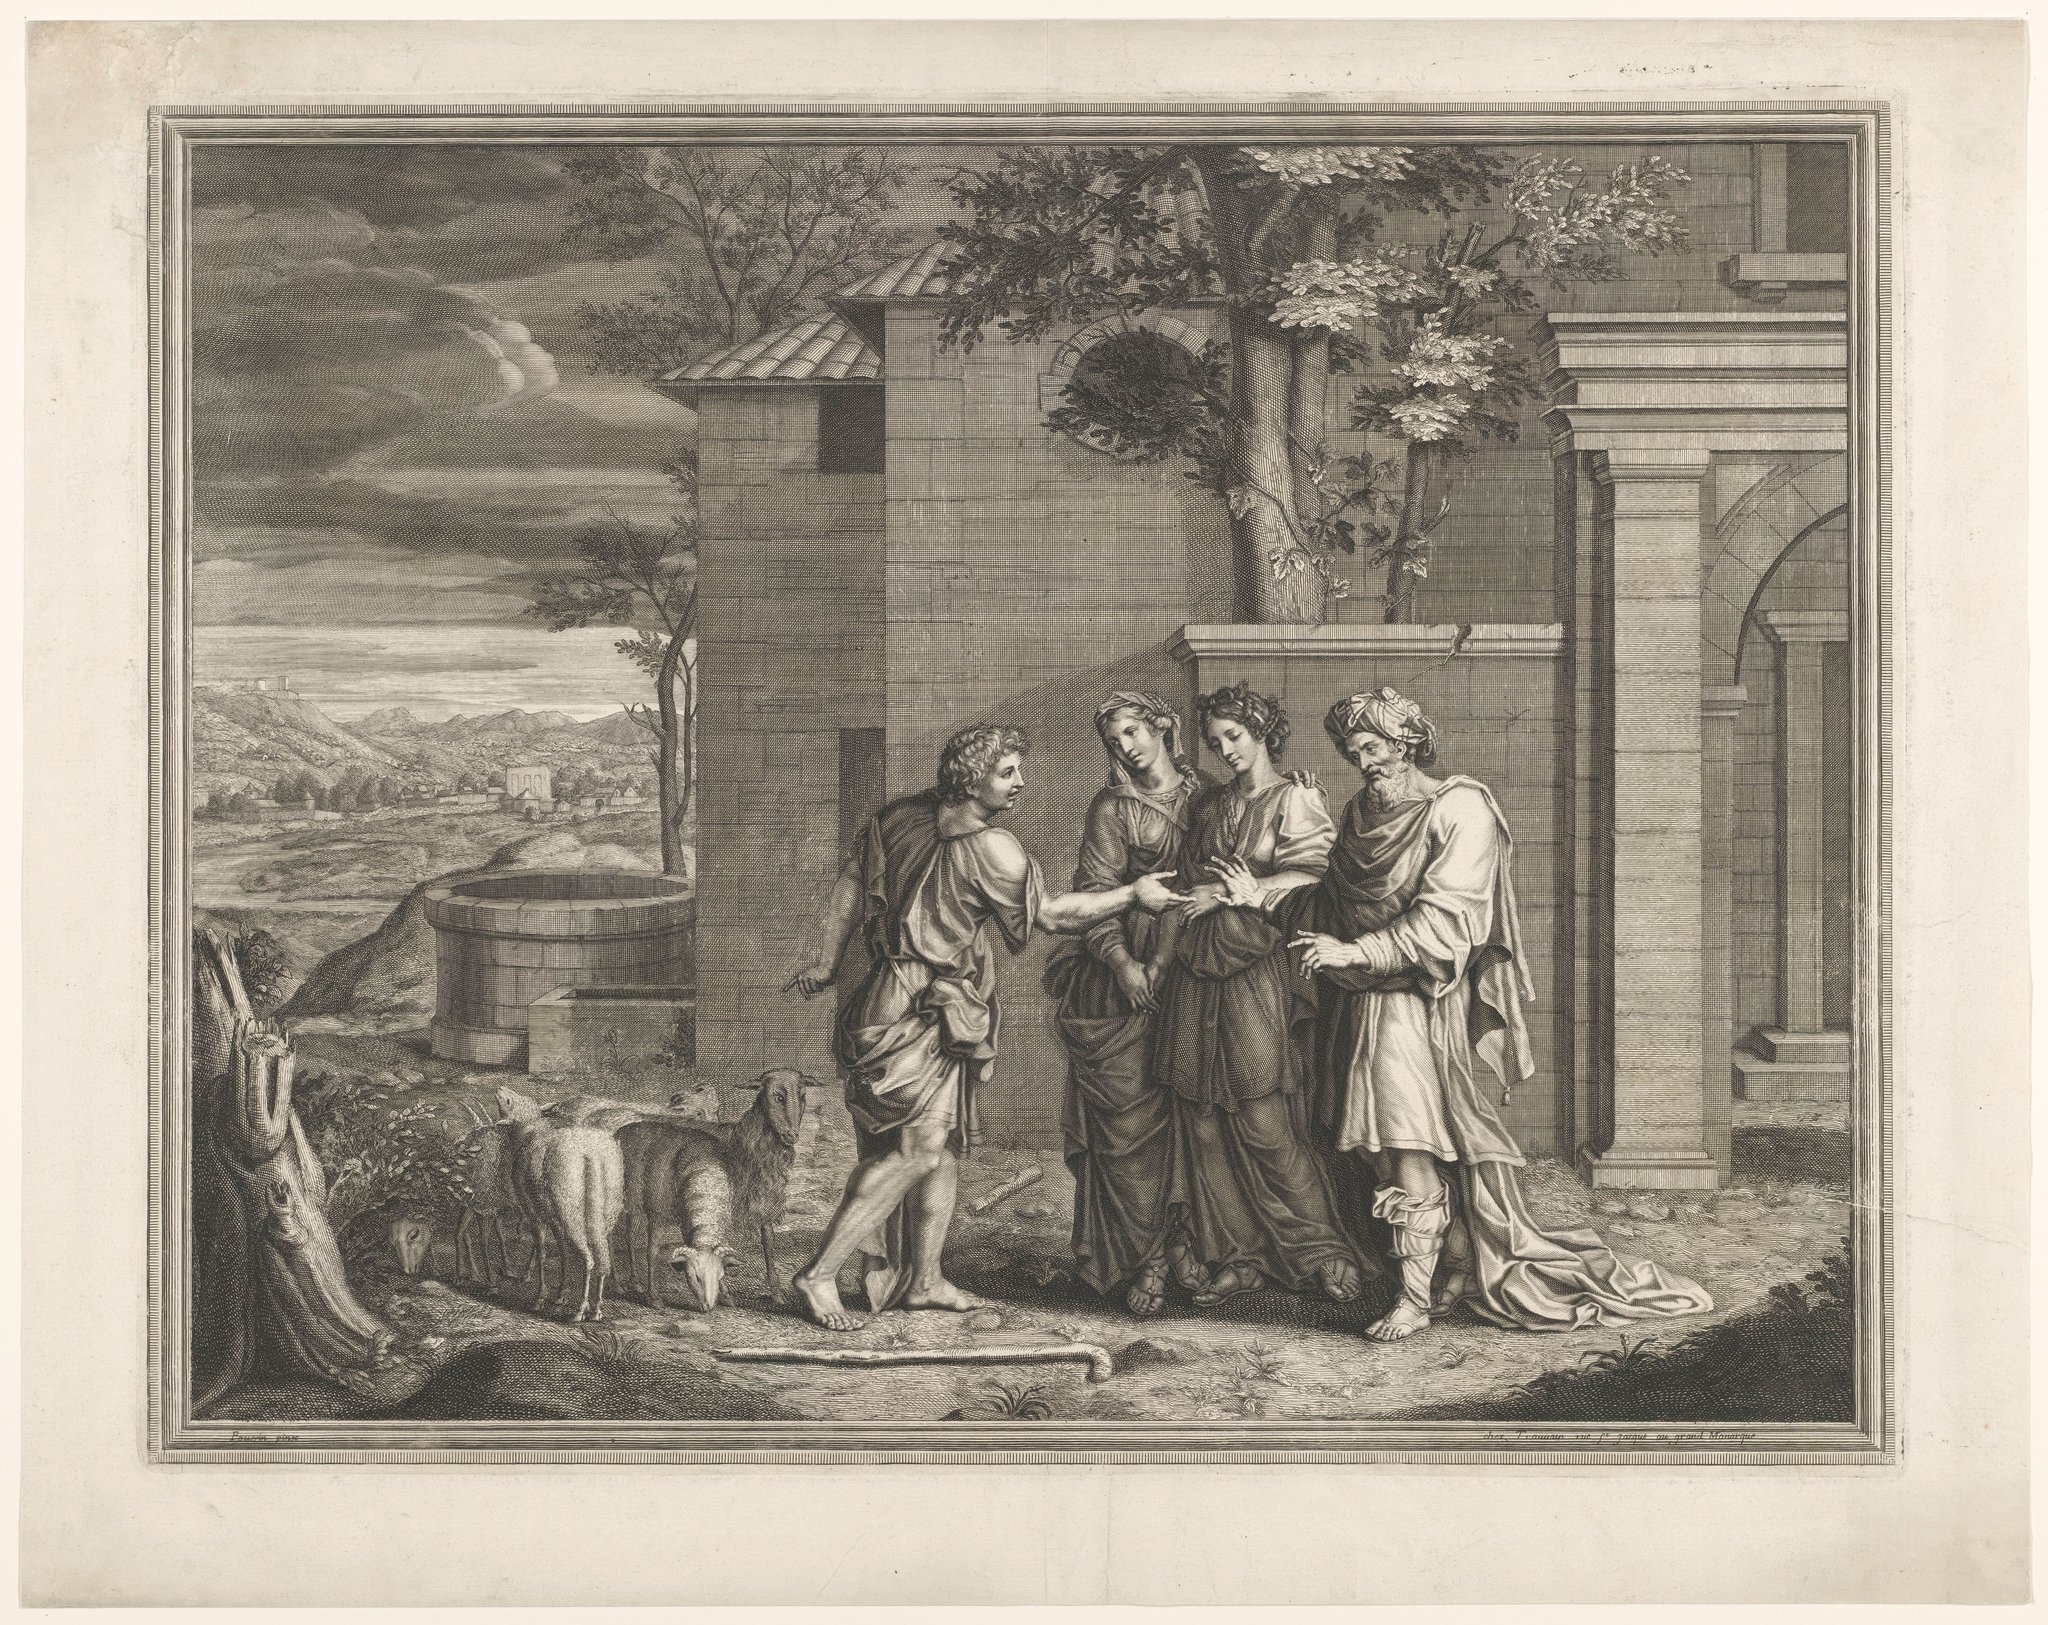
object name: print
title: Jakob vraagt aan Laban om de hand van Rachel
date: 1666-1708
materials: paper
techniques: engraving, etching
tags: jacob asks laban's permission to marry rachel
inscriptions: collector's mark: Lugt 240